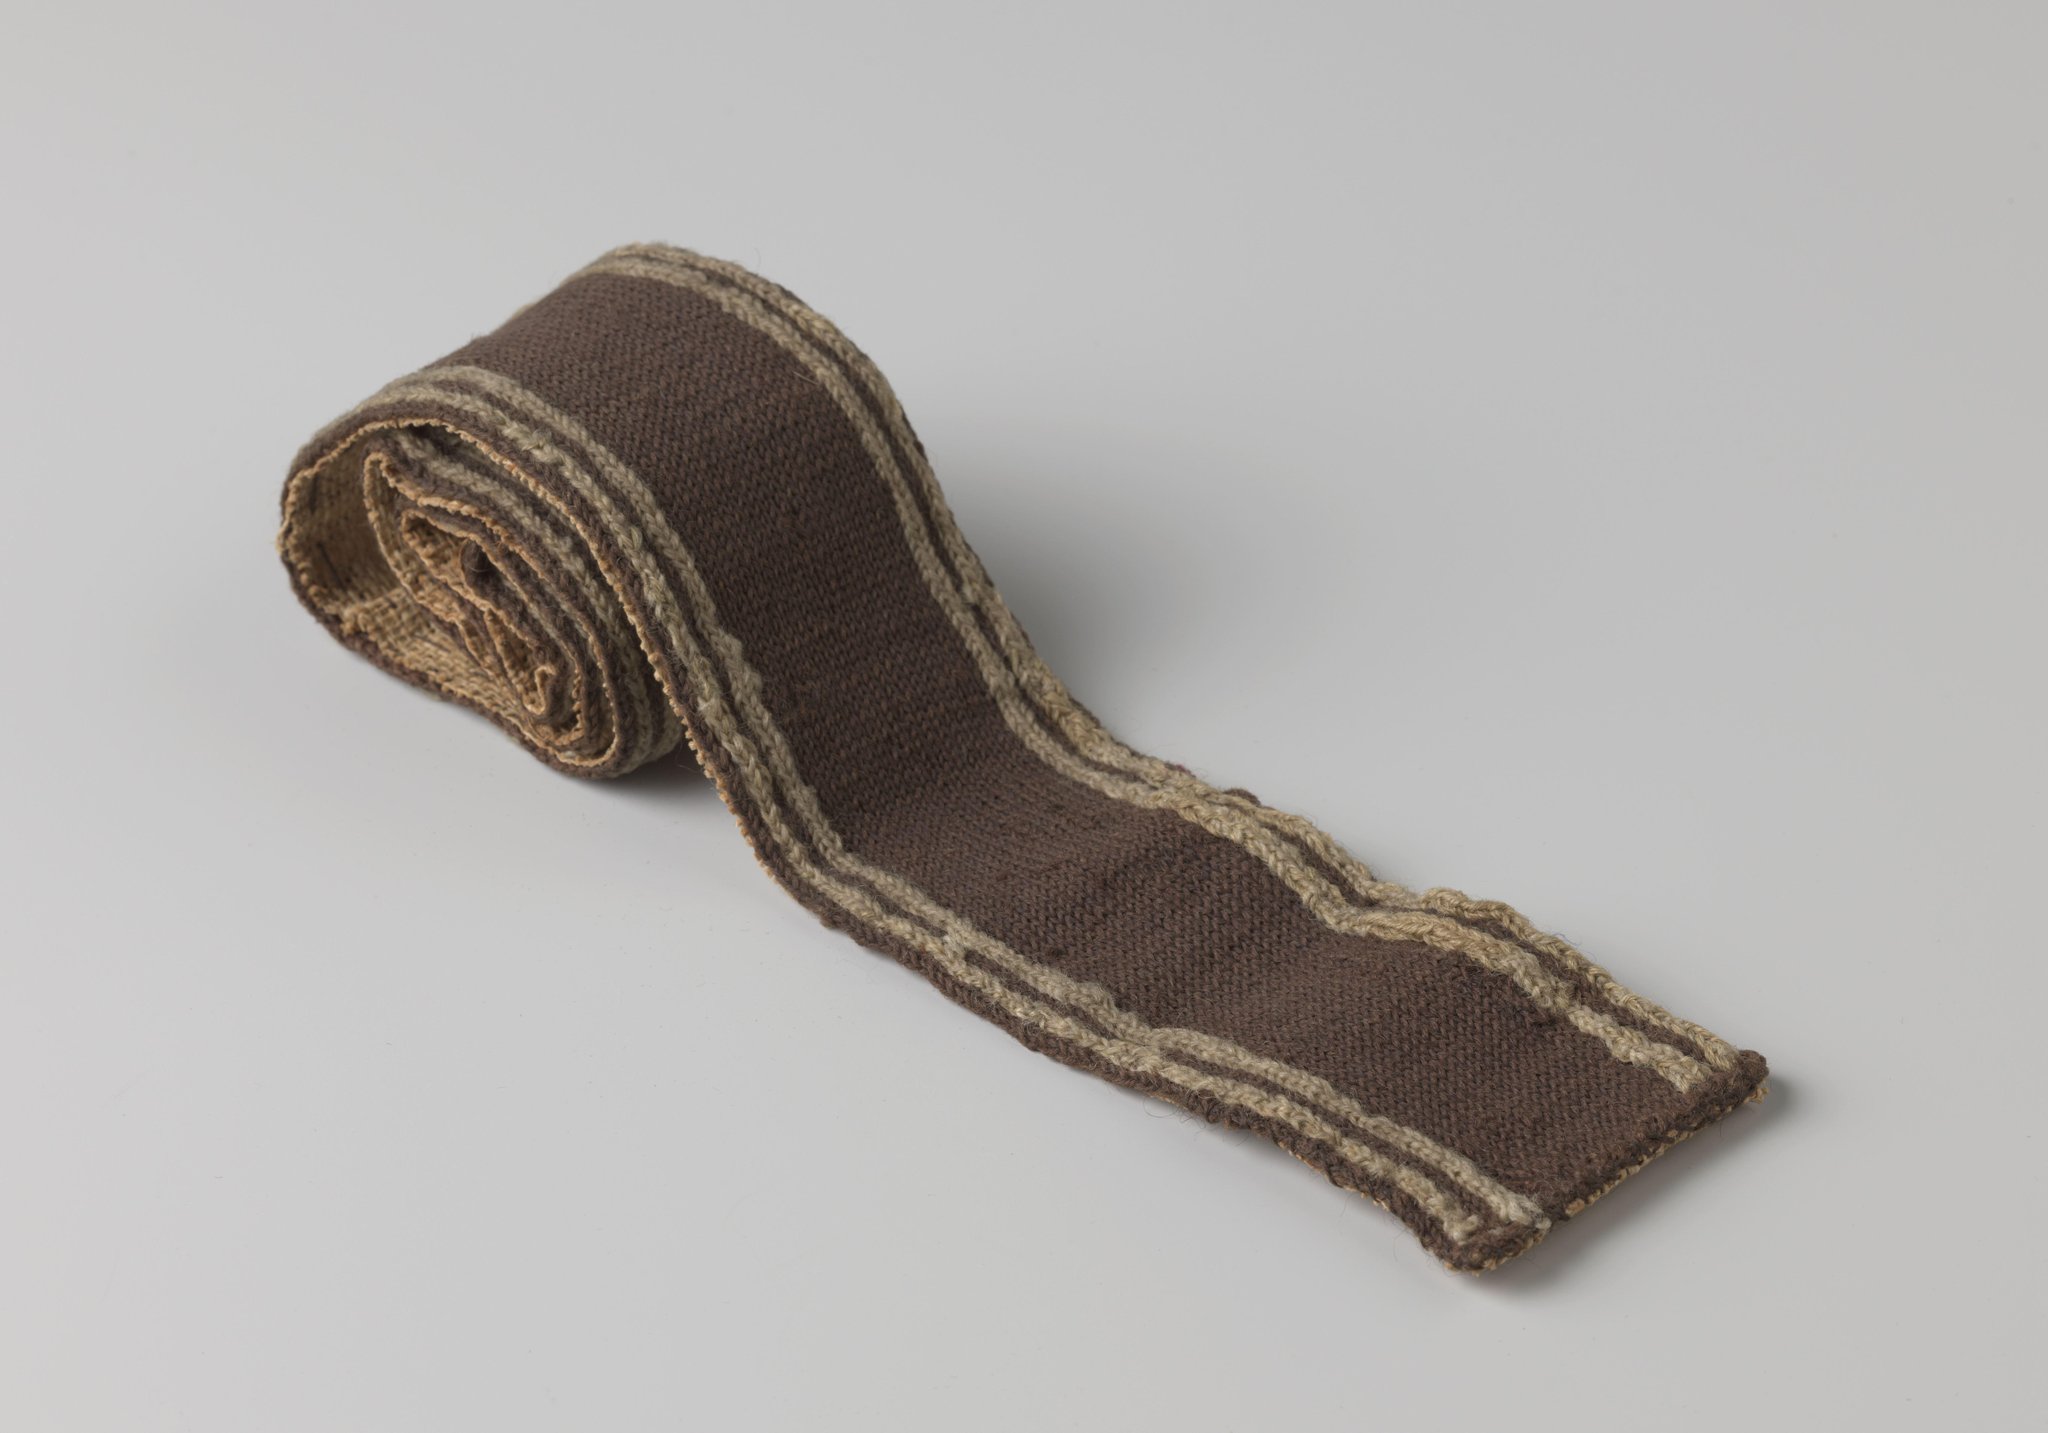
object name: miniature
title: Loper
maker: Anonymous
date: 1800-1899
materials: jute, wool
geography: amsterdam